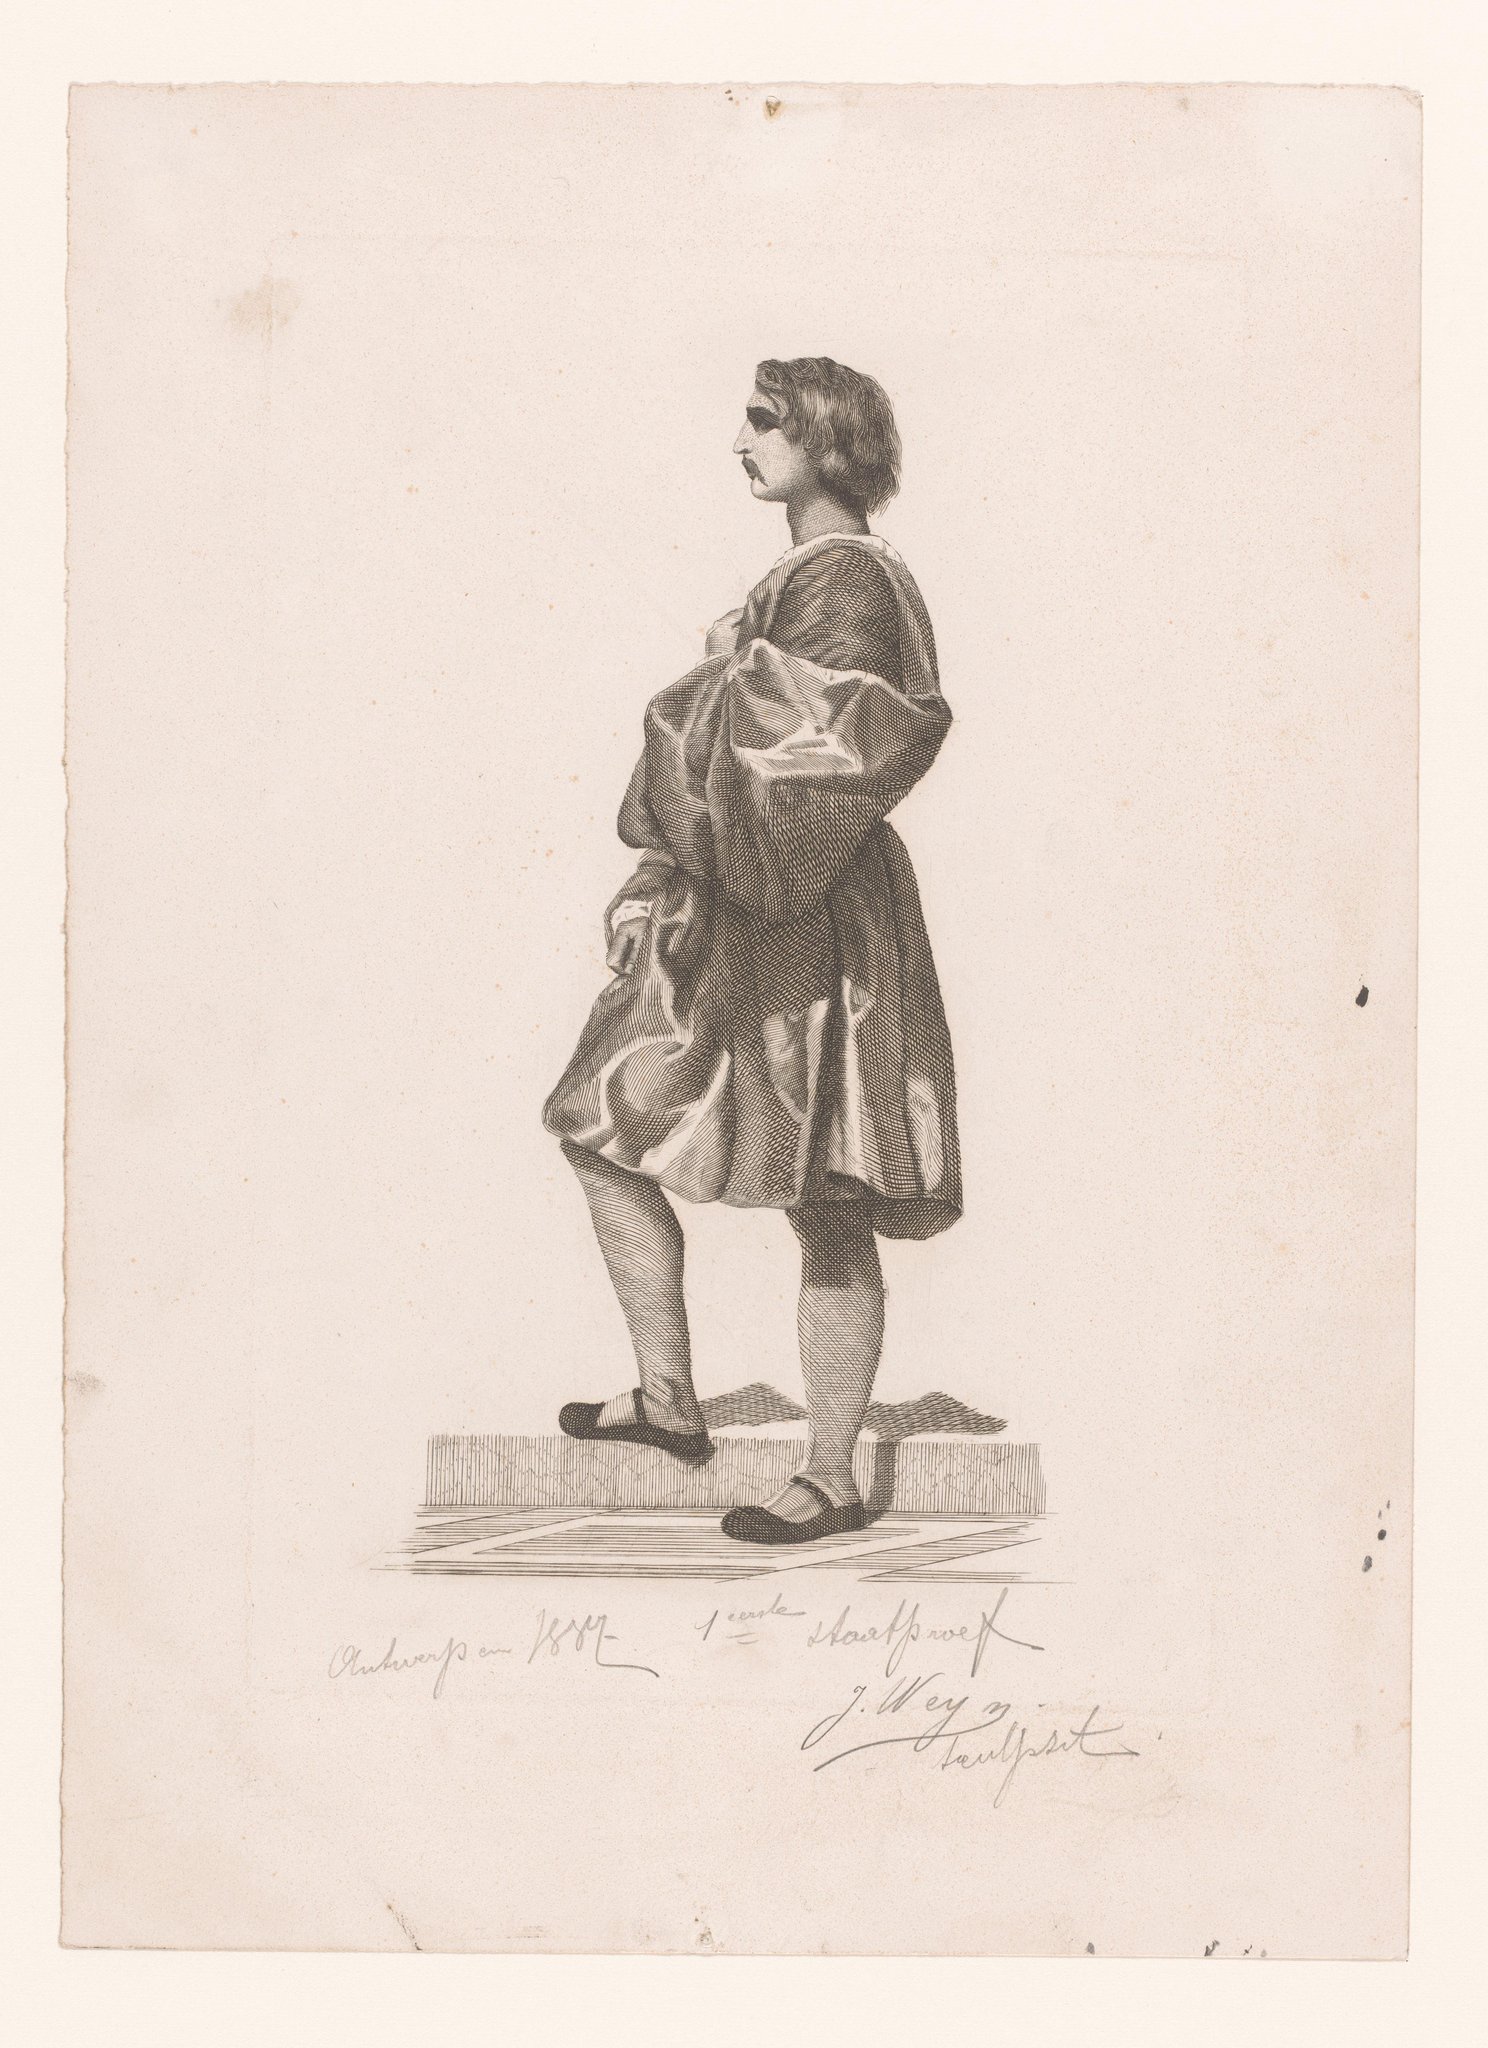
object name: print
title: Page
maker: j. weyn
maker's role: print maker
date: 1887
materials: paper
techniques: engraving, etching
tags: adult man, page ~ court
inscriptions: collector's mark: Lugt 2228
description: Sterfdatum van de prentmaker is onbekend. Daarom is voor de bepaling van de rechten van dit object gebruik gemaakt van de verwervingsdatum Rijksmuseum Amsterdam.